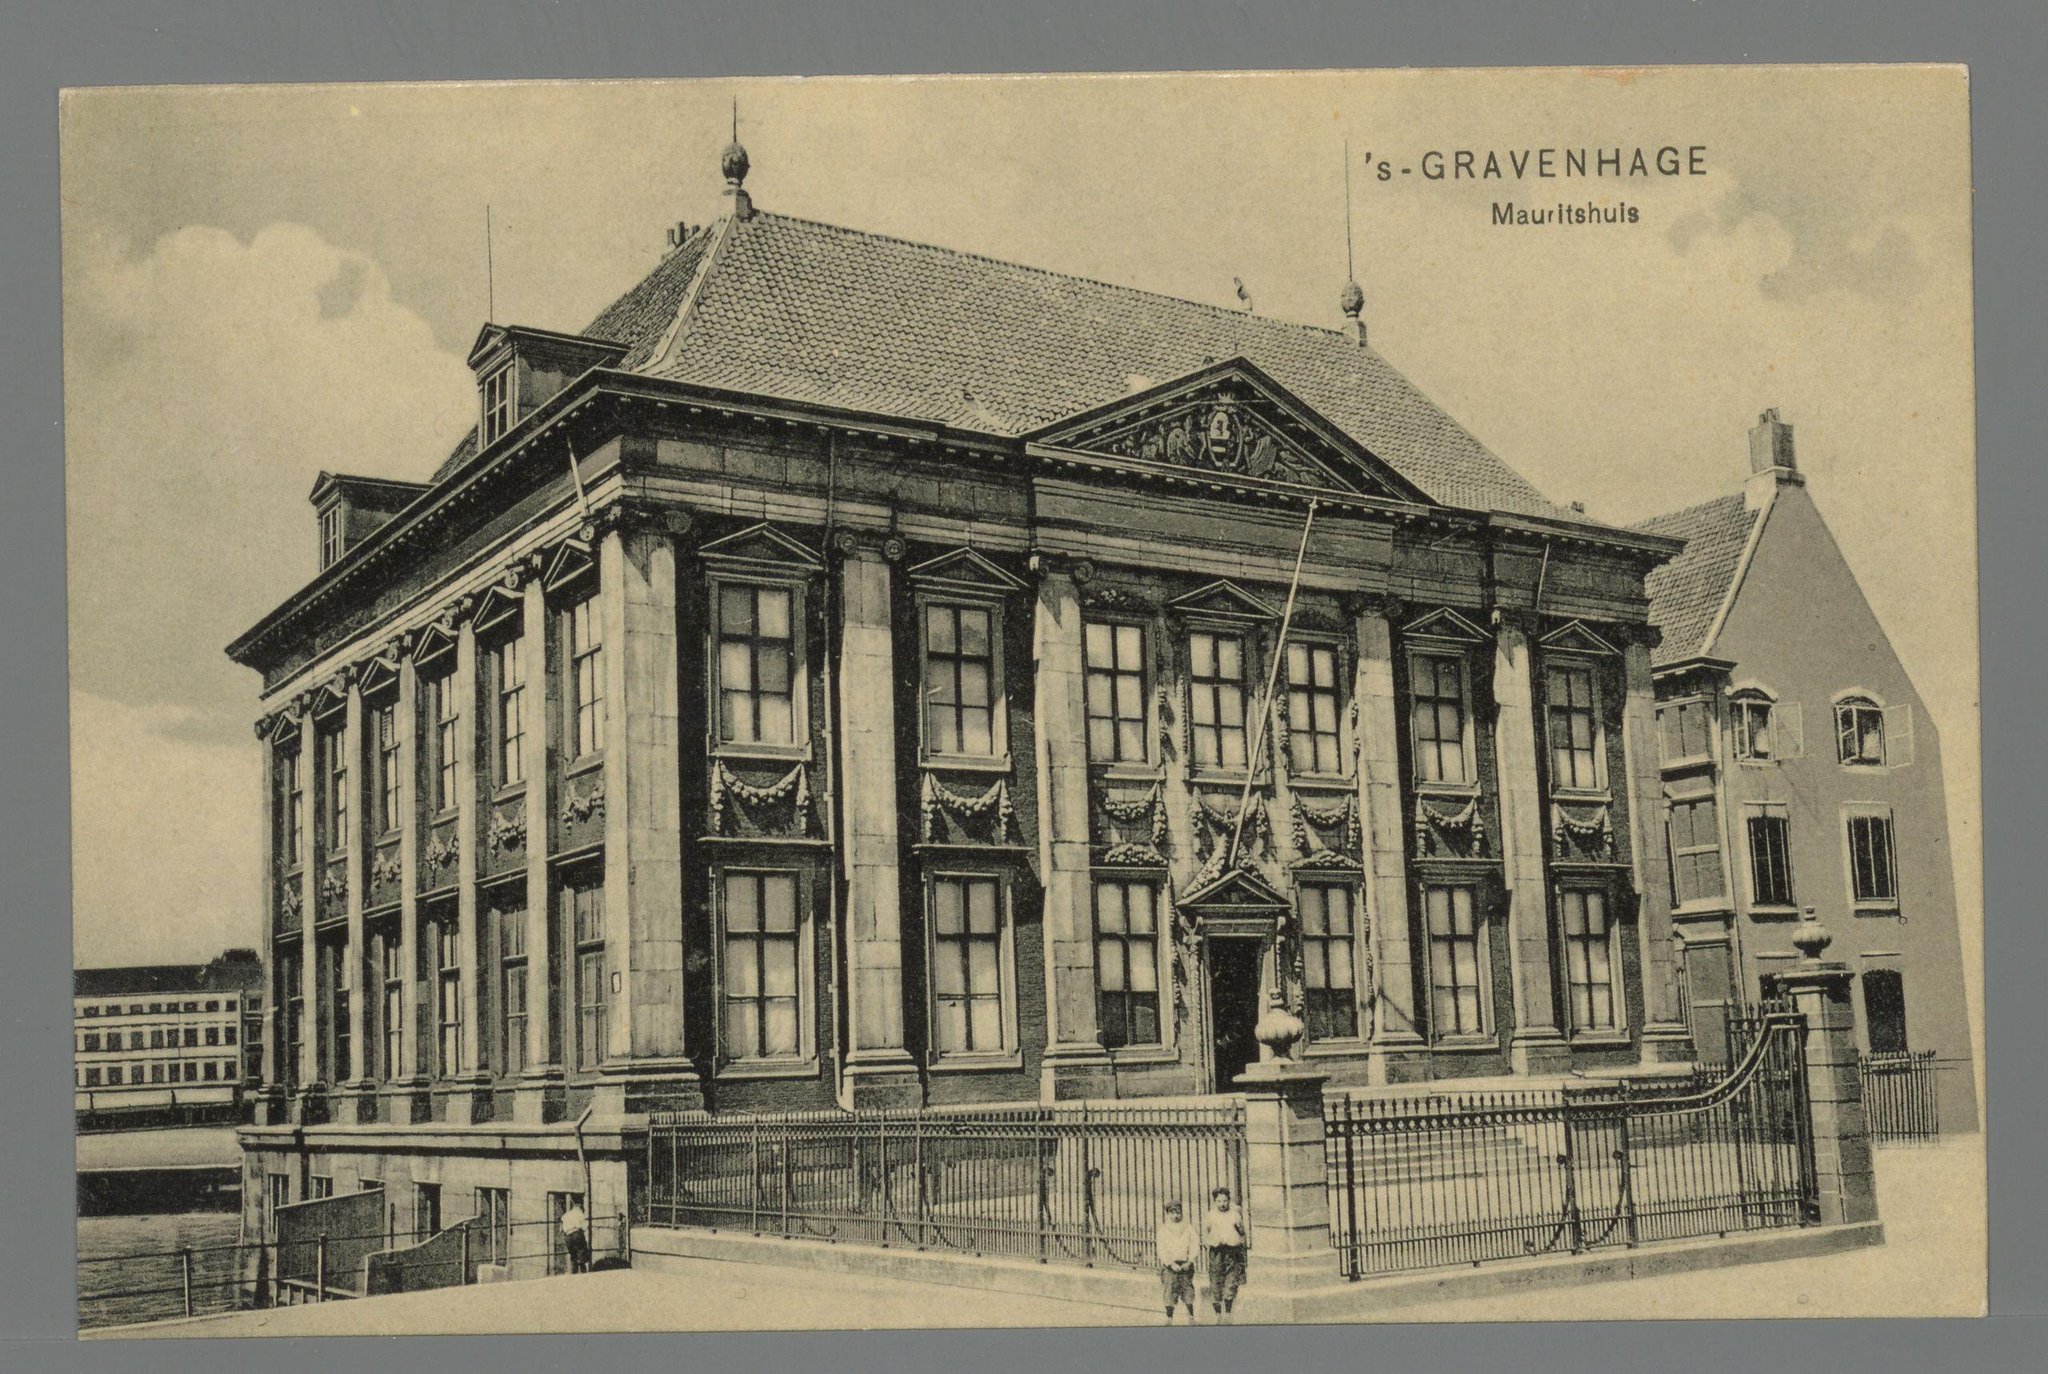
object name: photomechanical print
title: 's-Gravenhage. Mauritshuis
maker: Anonymous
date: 1906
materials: cardboard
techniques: photograph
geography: leipzig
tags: permanent exhibition, museum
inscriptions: date